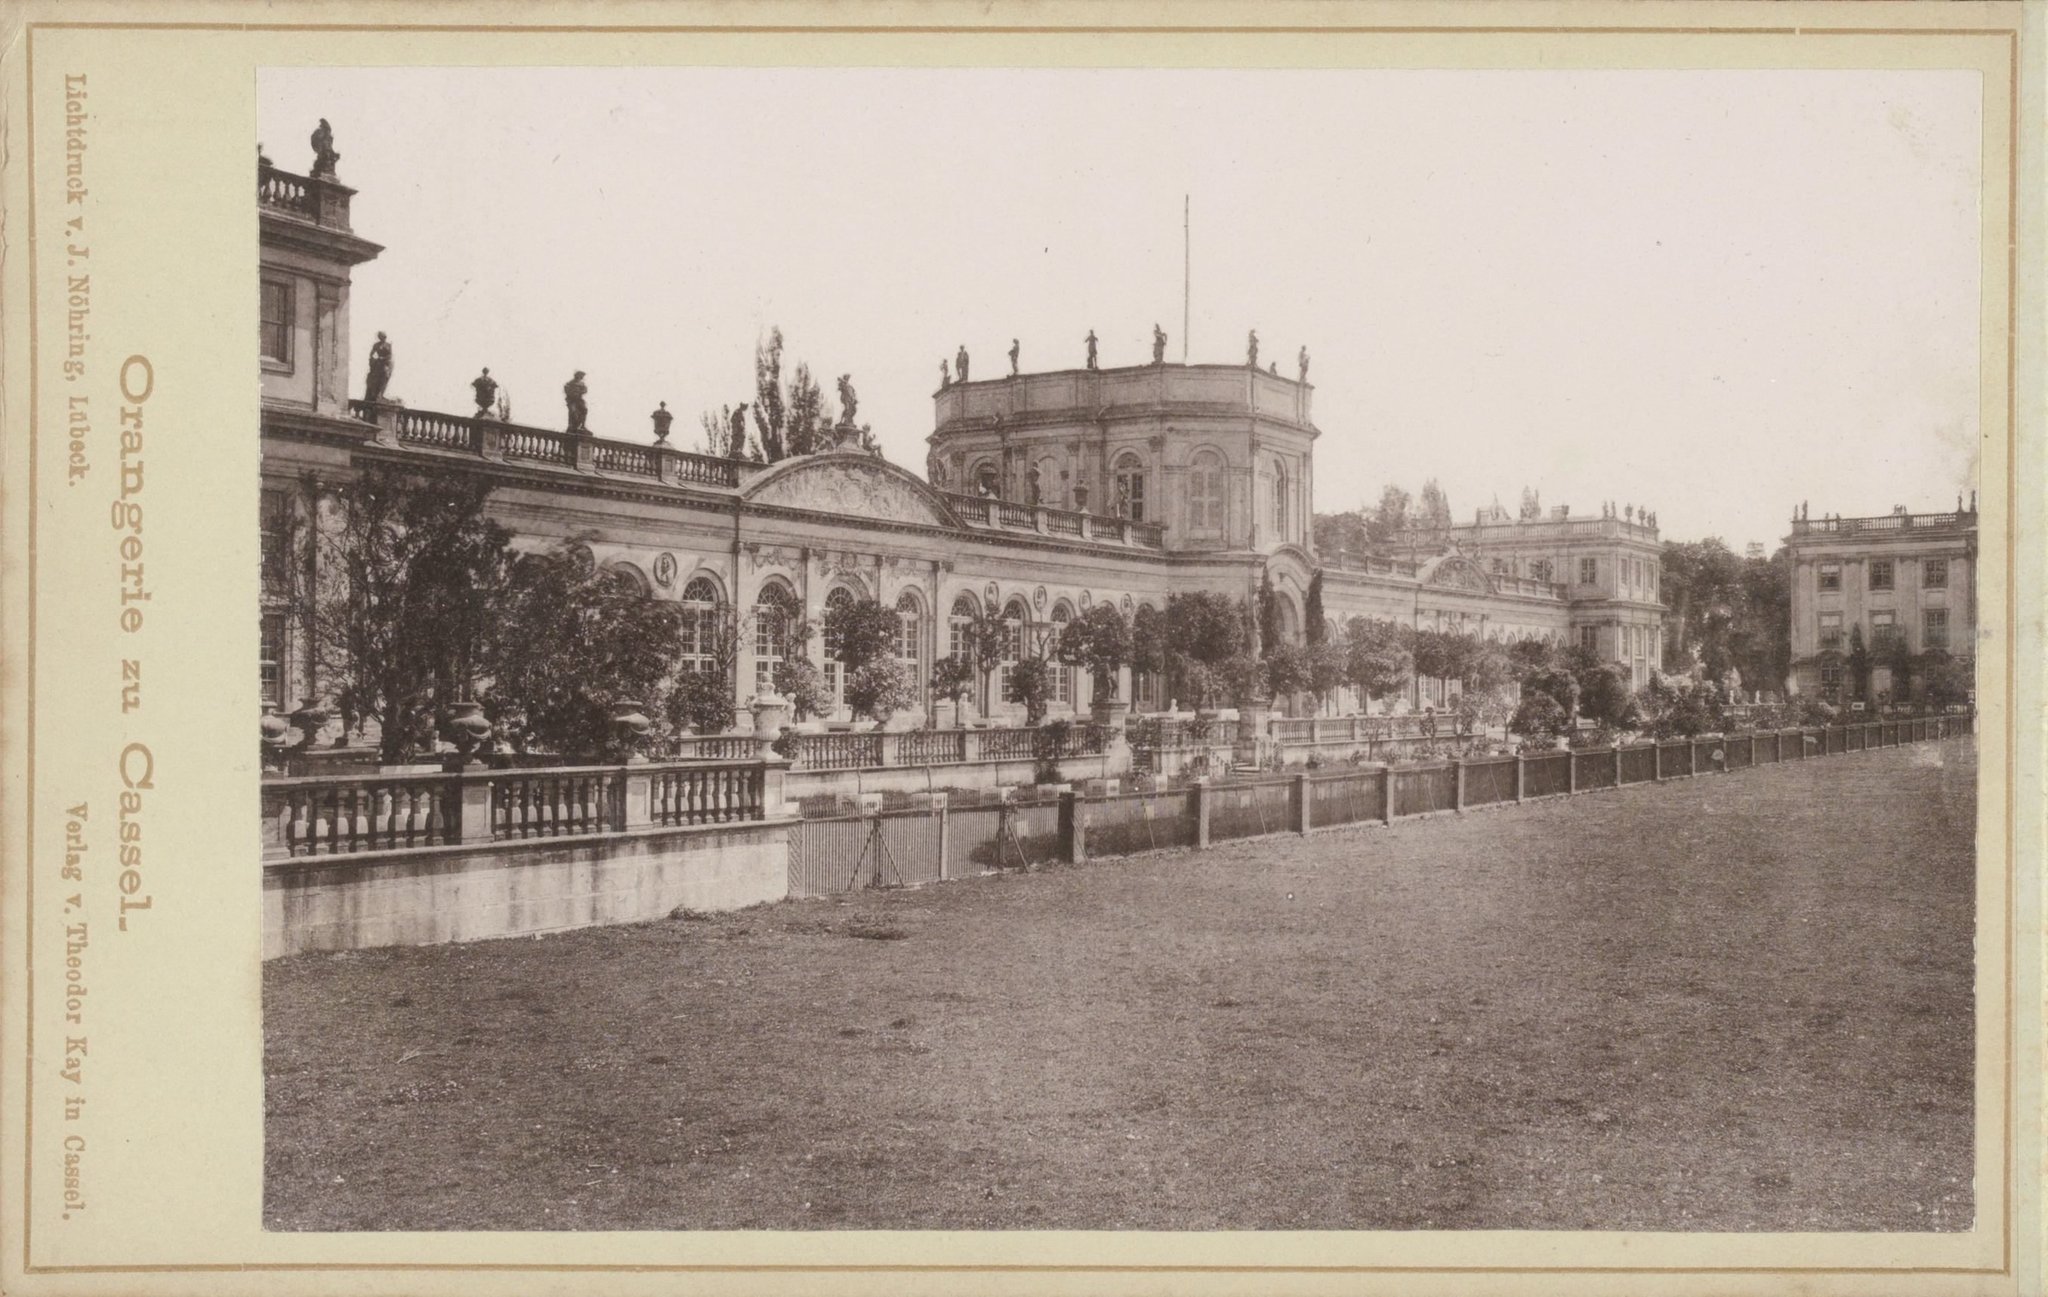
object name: photograph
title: Orangerie zu Cassel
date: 1870-1890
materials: cardboard, paper, photographic support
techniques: photograph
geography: kassel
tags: travelling; tourism, greenhouse, orangery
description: Onderdeel van Album met 38 foto's van een reis door de Harz.